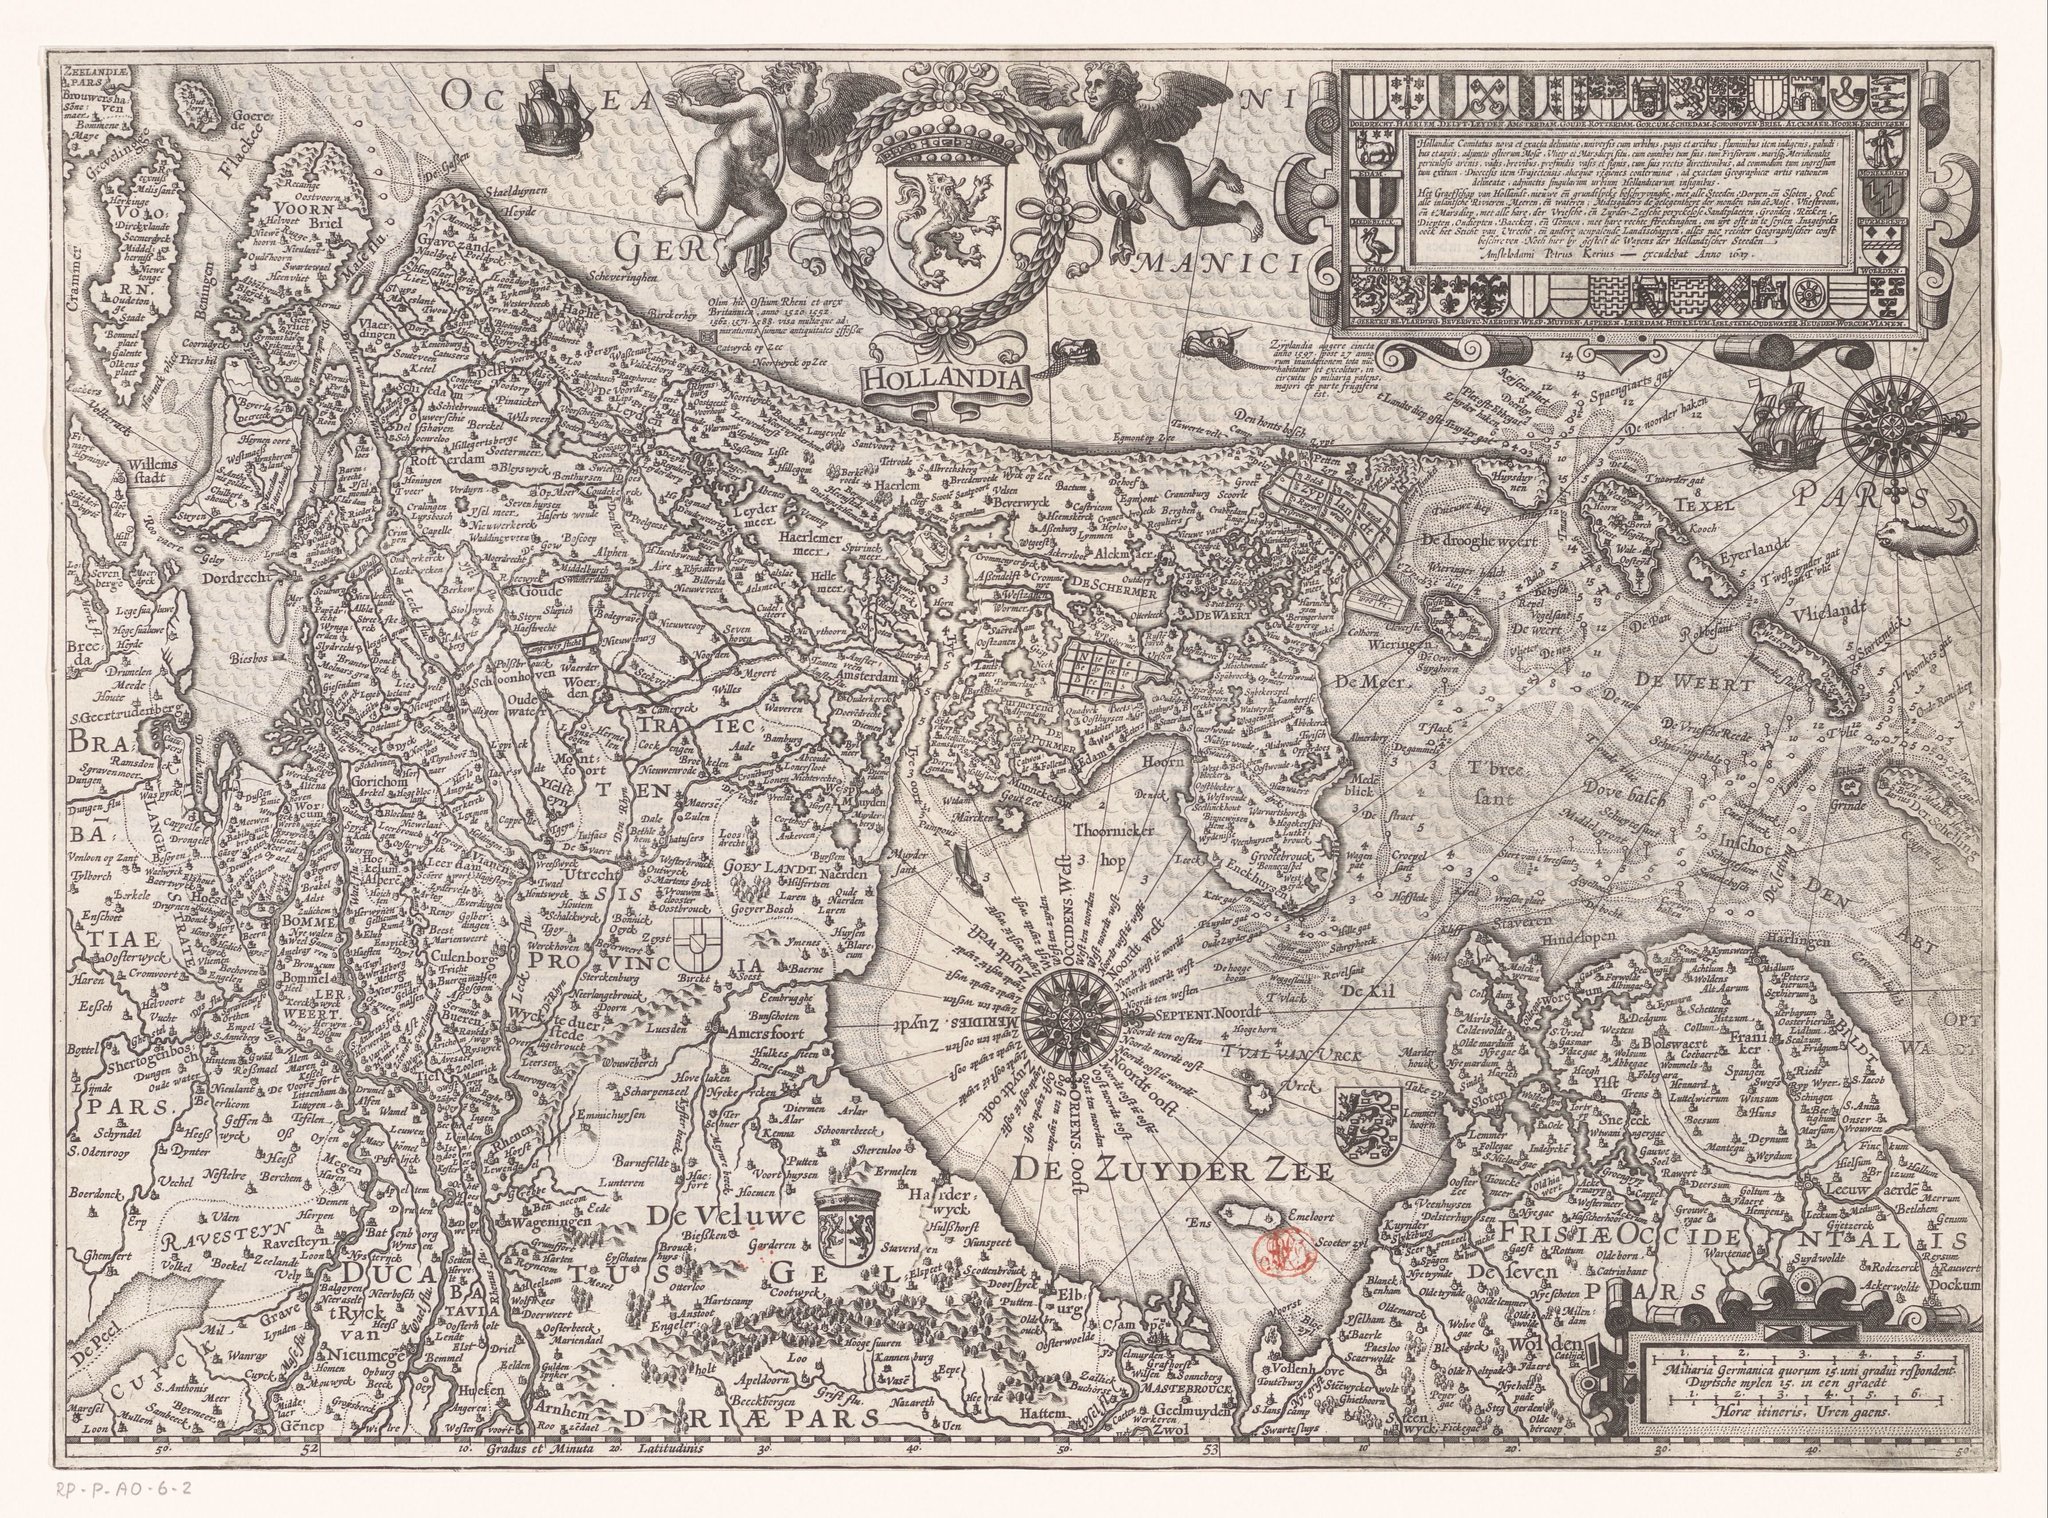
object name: print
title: Hollandia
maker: pieter van der keere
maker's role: print maker, publisher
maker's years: 1571-1646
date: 1617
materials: paper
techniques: engraving, letterpress printing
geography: amsterdam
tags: coat of arms (as symbol of the state, etc.), maps of separate countries or regions, holland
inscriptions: collector's mark: Lugt 195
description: Kaart van het graafschap Holland en omliggende gebieden. Boven in het midden twee putti met het wapen van het graafschap in een lauwerkrans, daaronder een banderol met de titel. Rechtsboven een cartouche met een beschrijving en wapens van Hollandse steden. Op de kaart ter hoogte van de Veluwe het wapen van Gelderland. Rechts in de Zuiderzee het wapen van Friesland. Rechtsonder twee schaalstokken: Miliarie Germanica quorum 15.uni gradui respondent / Duytsche mylen 15. in een graedt; Horae itineris / Uren gaens. Gradenverdeling langs de onderkant. Oriëntatie: noorden rechts. Op verso Latijnse tekst.